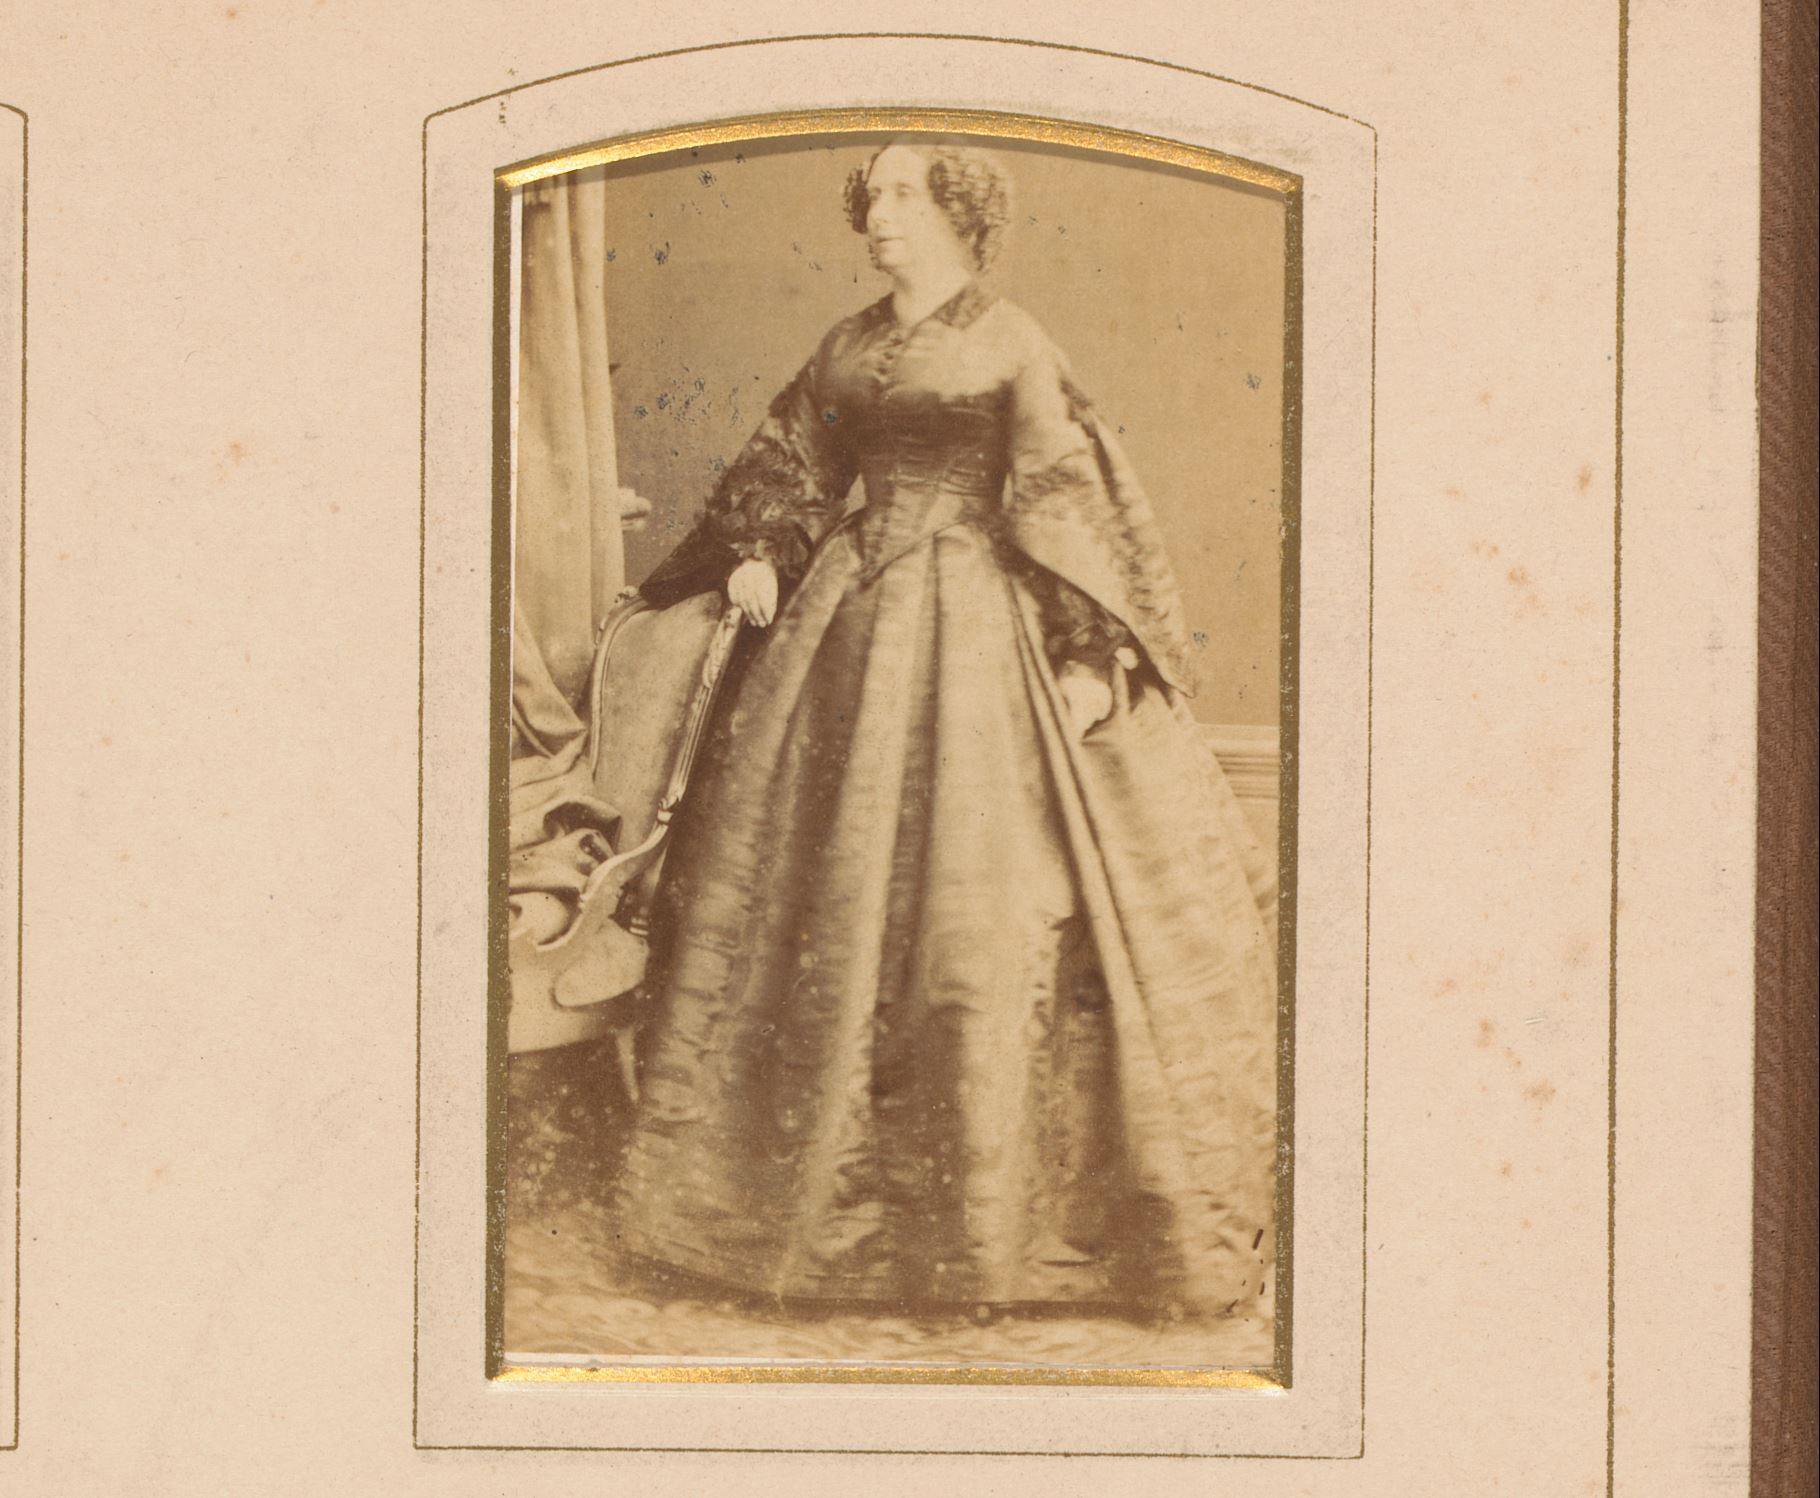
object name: album leaf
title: Portret van Sophia Frederica Mathilda, koningin der Nederlanden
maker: robert severin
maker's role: fotograaf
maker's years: 1839-1888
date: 1860-1877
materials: cardboard, photographic support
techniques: albumen print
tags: the hague, sophia frederika mathilda van württemberg, historical persons - bb - woman, queen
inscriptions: inscription: ‘R. SEVERIN./ PHOTOGRAPHE DE S.M. LE ROI,/ Noordeinde, 109,/ LA HAYE.’, name: ‘Koningin Sophie’, annotation: ‘Koningin van Holland’